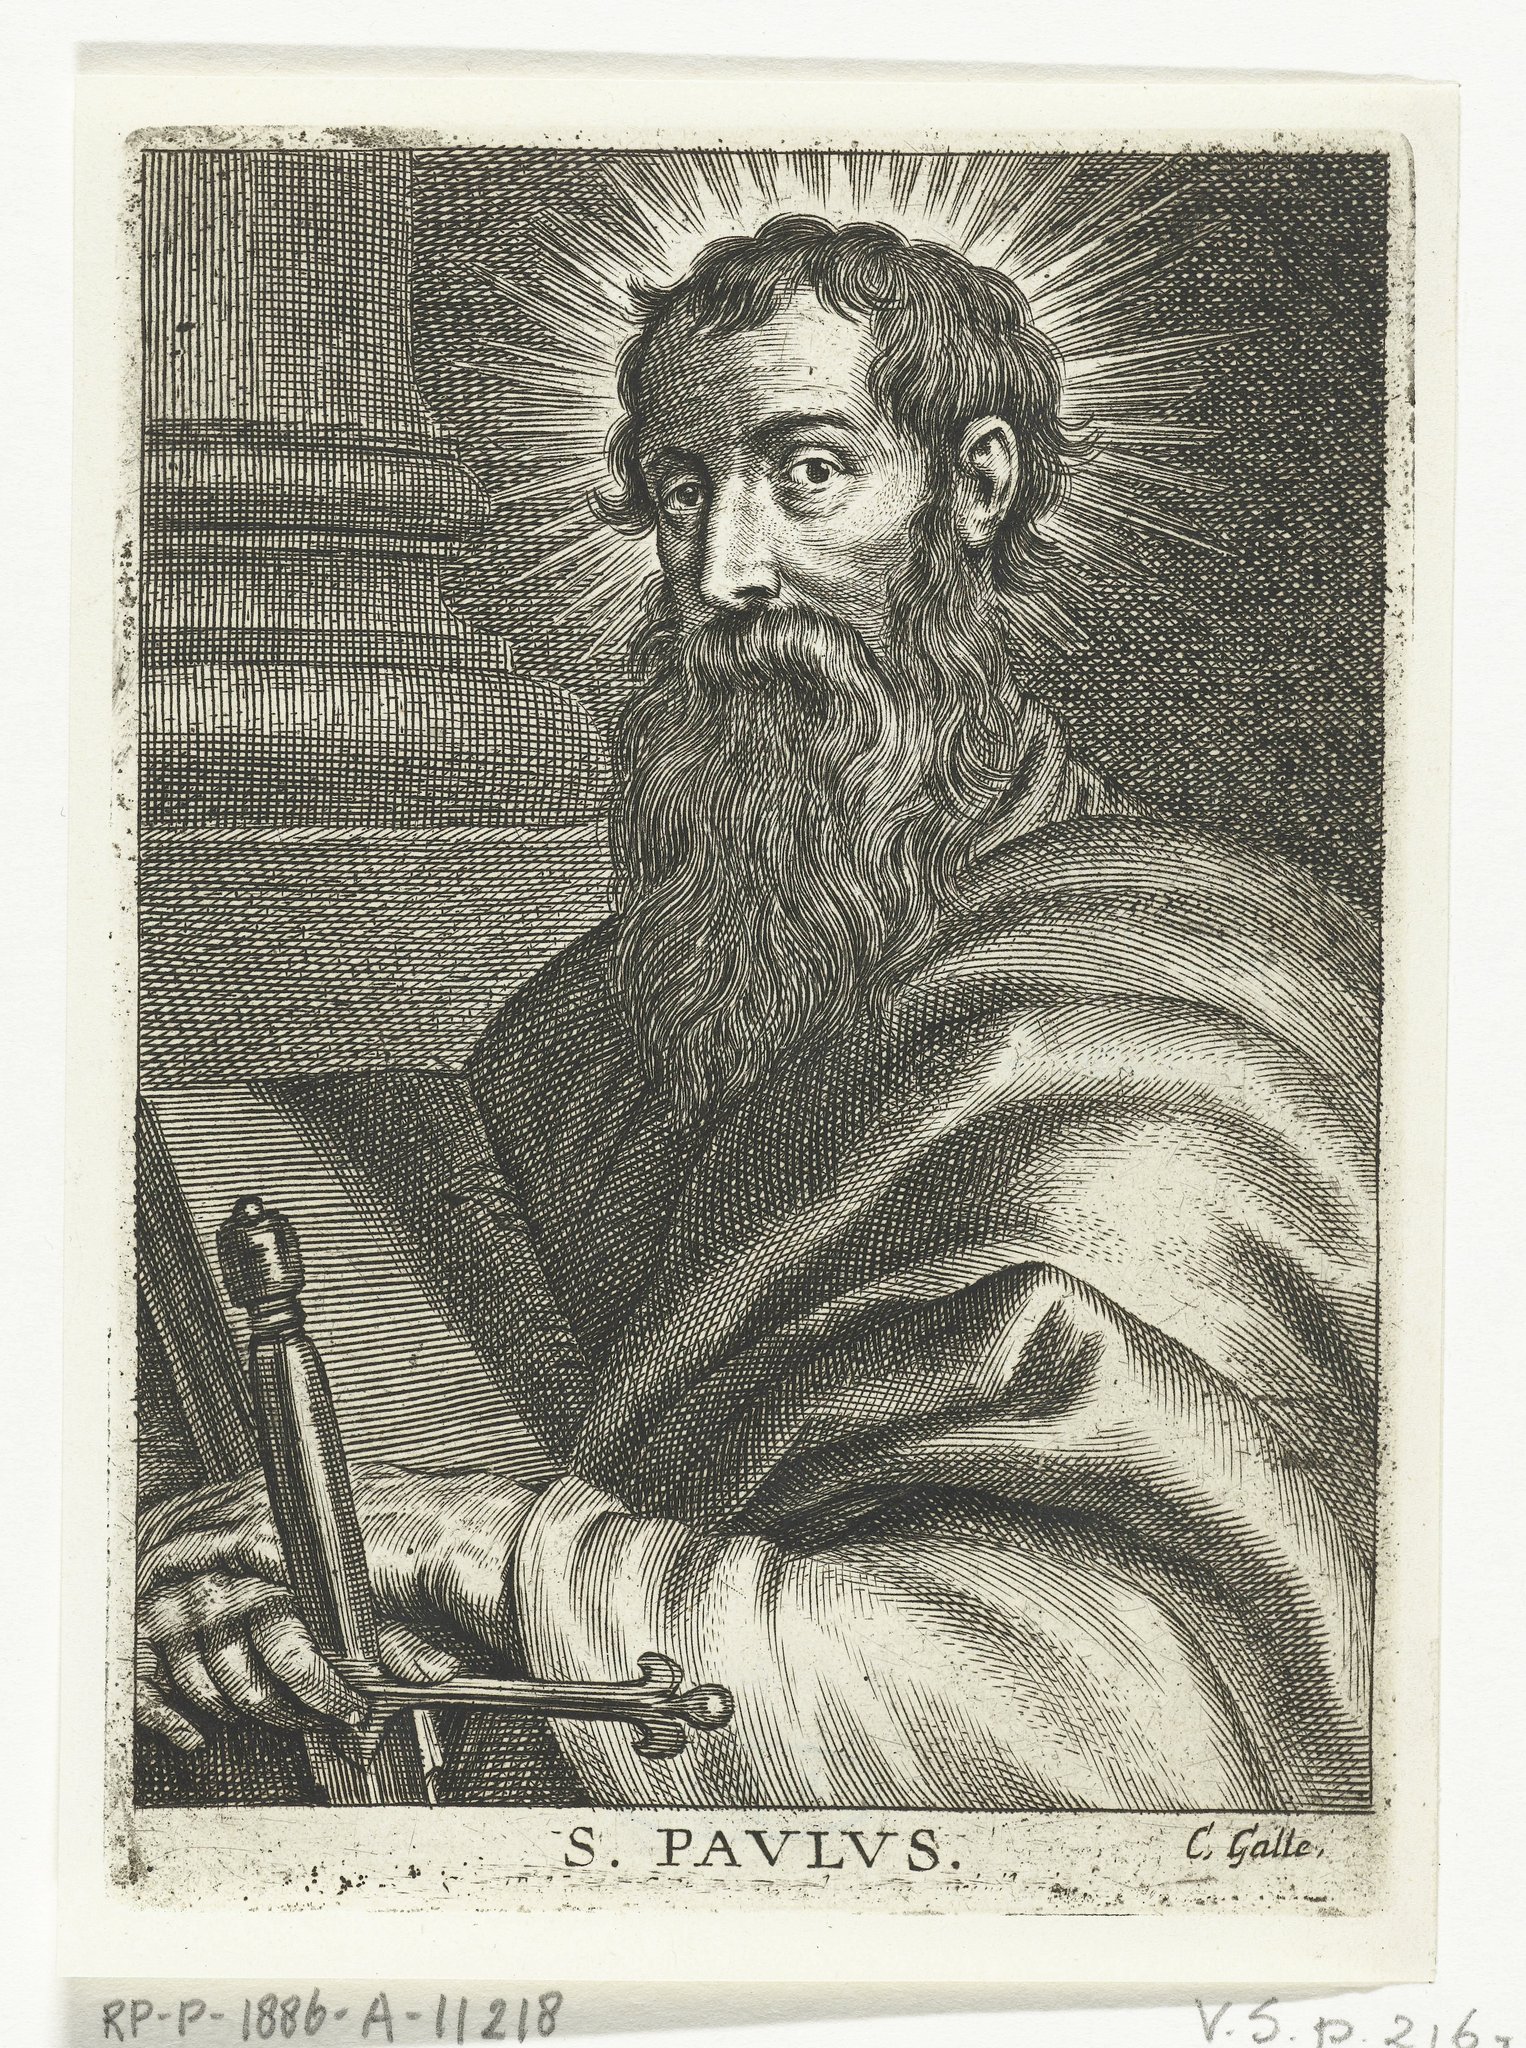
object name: print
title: S. Pavlvs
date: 1596-1678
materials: paper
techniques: engraving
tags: the apostle paul of tarsus; possible attributes: book, scroll, sword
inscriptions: collector's mark: Lugt 2228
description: Prent uit serie Vélins met negentig prenten naar ontwerp van Peter Paul Rubens. In de bronnen vinden we uiteenlopende gegevens over aantal en samenstelling van de serie. Hollstein hanteert het aantal van negentig prenten. De reeks Vélins in de collectie van het RMA bevat verschillende staten afkomstig uit meerdere uitgaven welke moeilijk te duiden zijn. Sommige dragen het originele adres van Schelte Adamsz. Bolswert als graveur en uitgever, op andere exemplaren is deze naam verwijderd (duidelijk zichtbaar!) en vervangen door de naam Cornelis Galle (II). De prenten met de naam van uitgever Galle zijn vaak opgewerkt. We treffen nog een andere naam van een uitgever bij enkele prent aan: Martien van den Enden. Herkomst uit meerdere uitgaven spreekt ook uit afwijkende opschriften in Nederlands en Latijn en variaties op dezelfde thema's welke misschien nooit langs elkaar in dezelfde serie gebruikt werden.